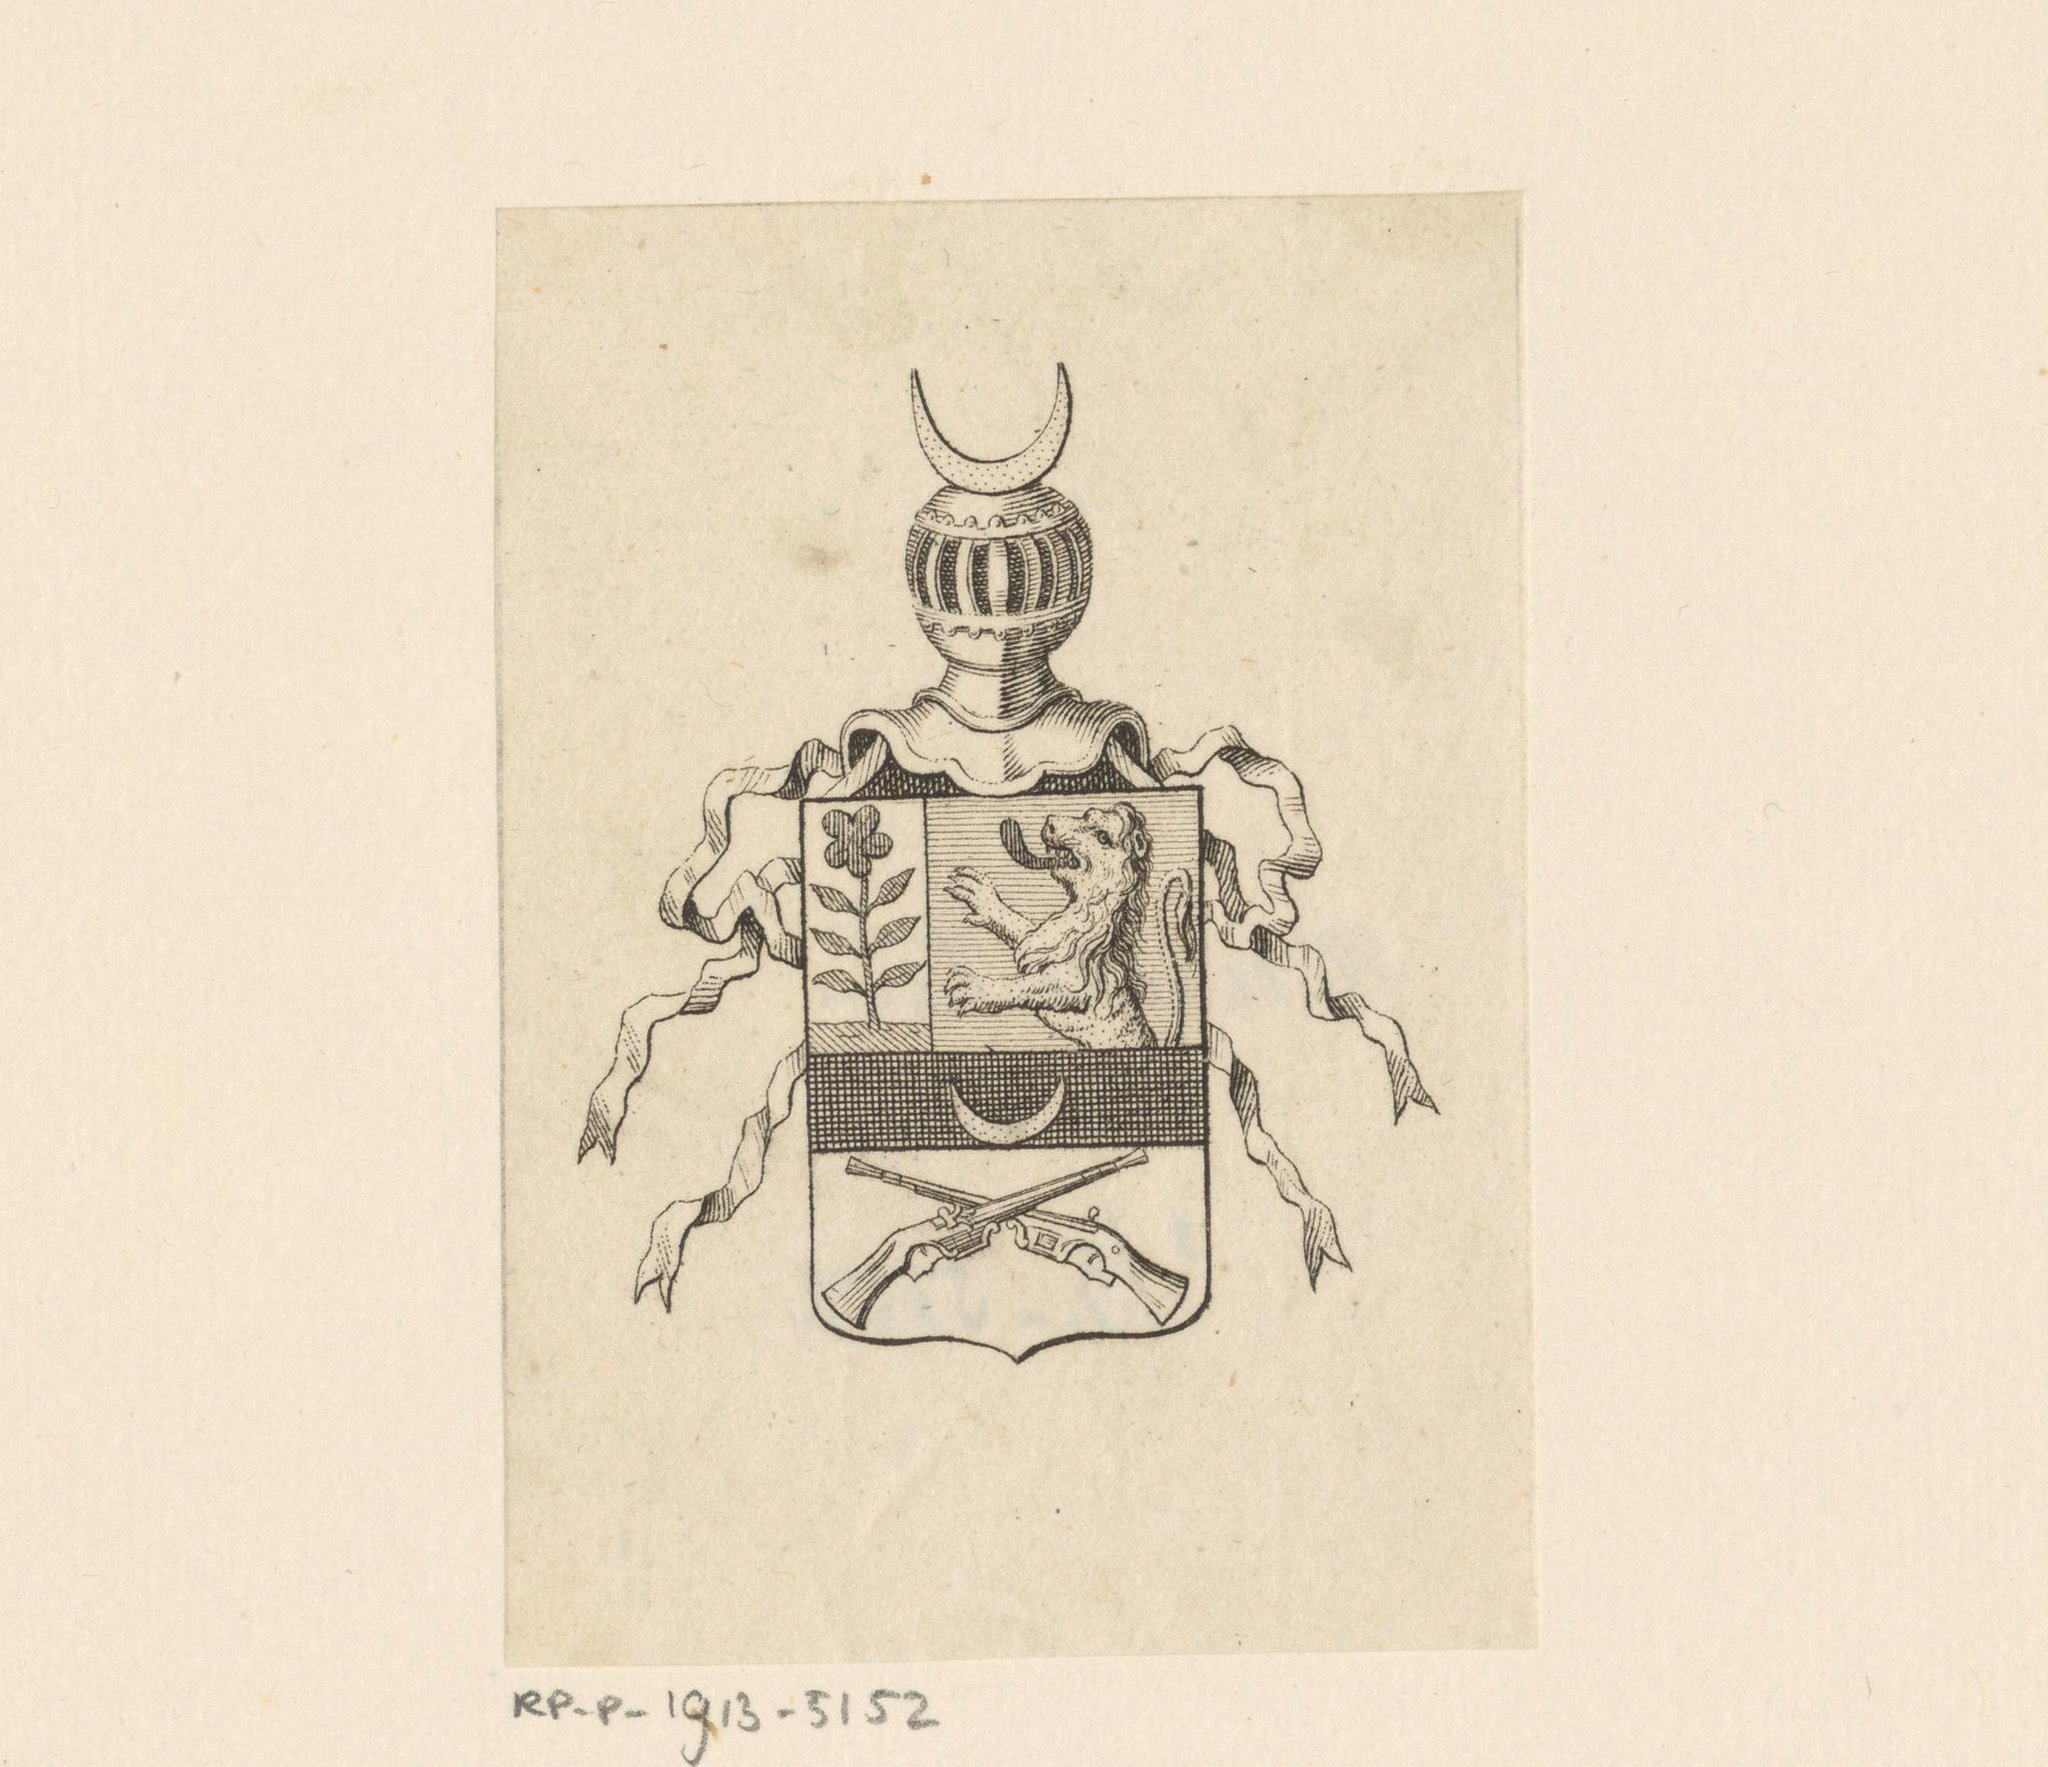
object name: bookplate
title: Ex libris van Mousquetier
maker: Anonymous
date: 1750-1849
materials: paper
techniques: etching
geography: netherlands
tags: firearms: rifle, beasts of prey, predatory animals: lion, armorial bearing, heraldry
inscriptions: collector's mark: Lugt 2760, collector's mark: Lugt 2233